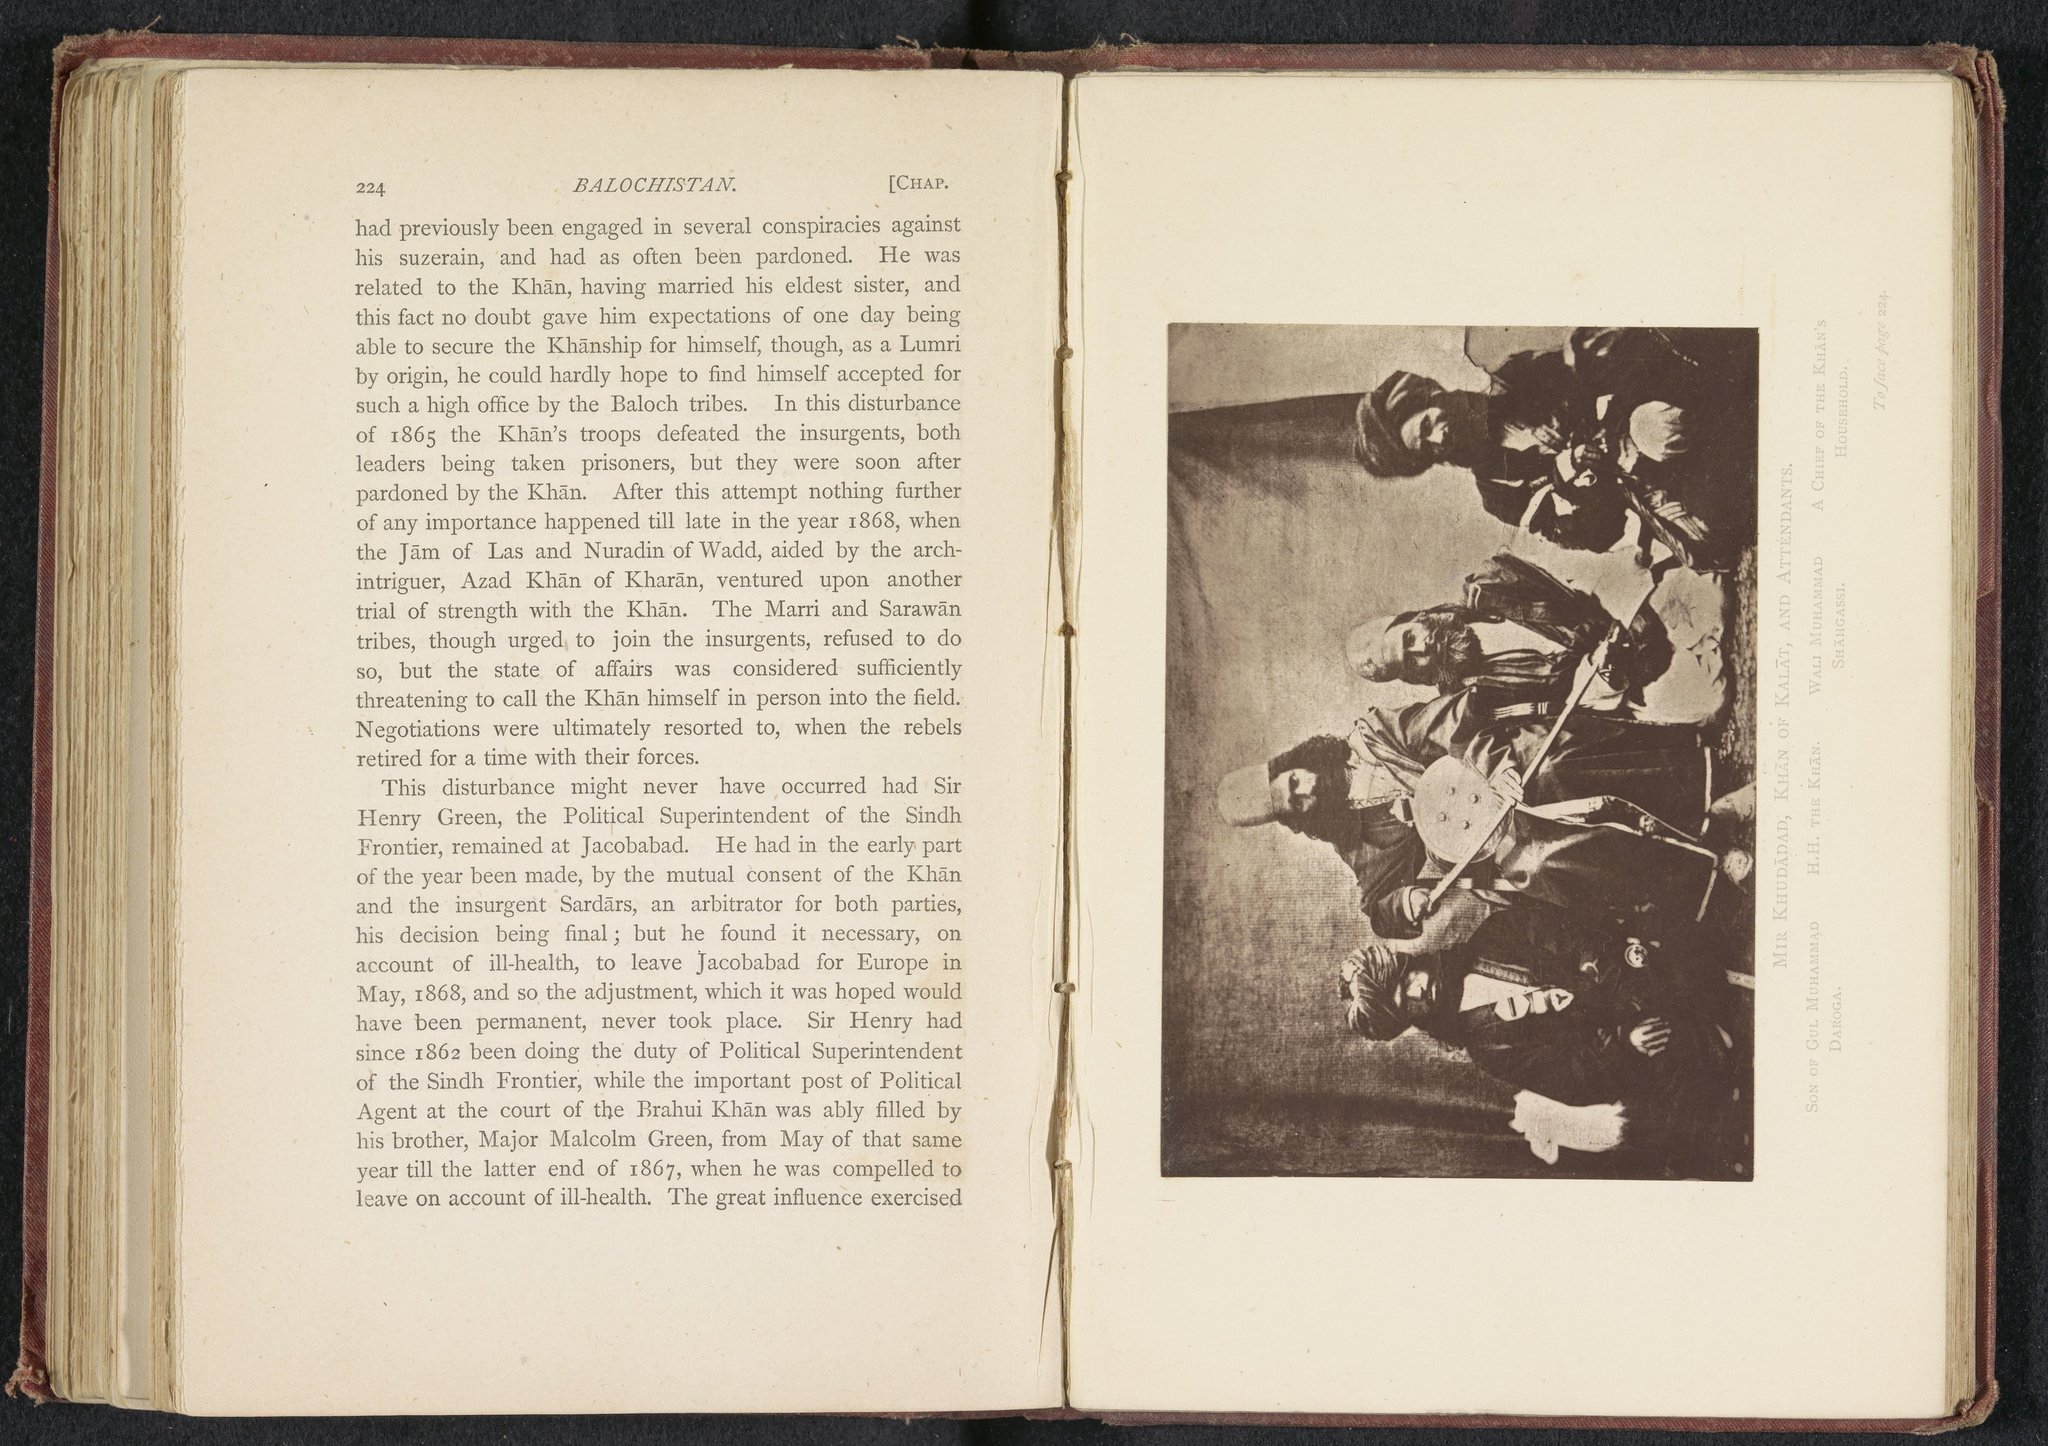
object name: photomechanical print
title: Mir Khudādad, Khān of Kalāt, and attendants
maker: Anonymous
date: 1866-1876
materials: paper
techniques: woodburytype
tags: head-gear: turban, ruler, sovereign, royal household; courtiers, retinue, train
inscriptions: inscription: ‘Son of Gul Muhammad Daroga. H.H. The Khān. Wali Muhammad Shāhgassi. A chief of the Khān's household.’, inscription: ‘To face page 224.’